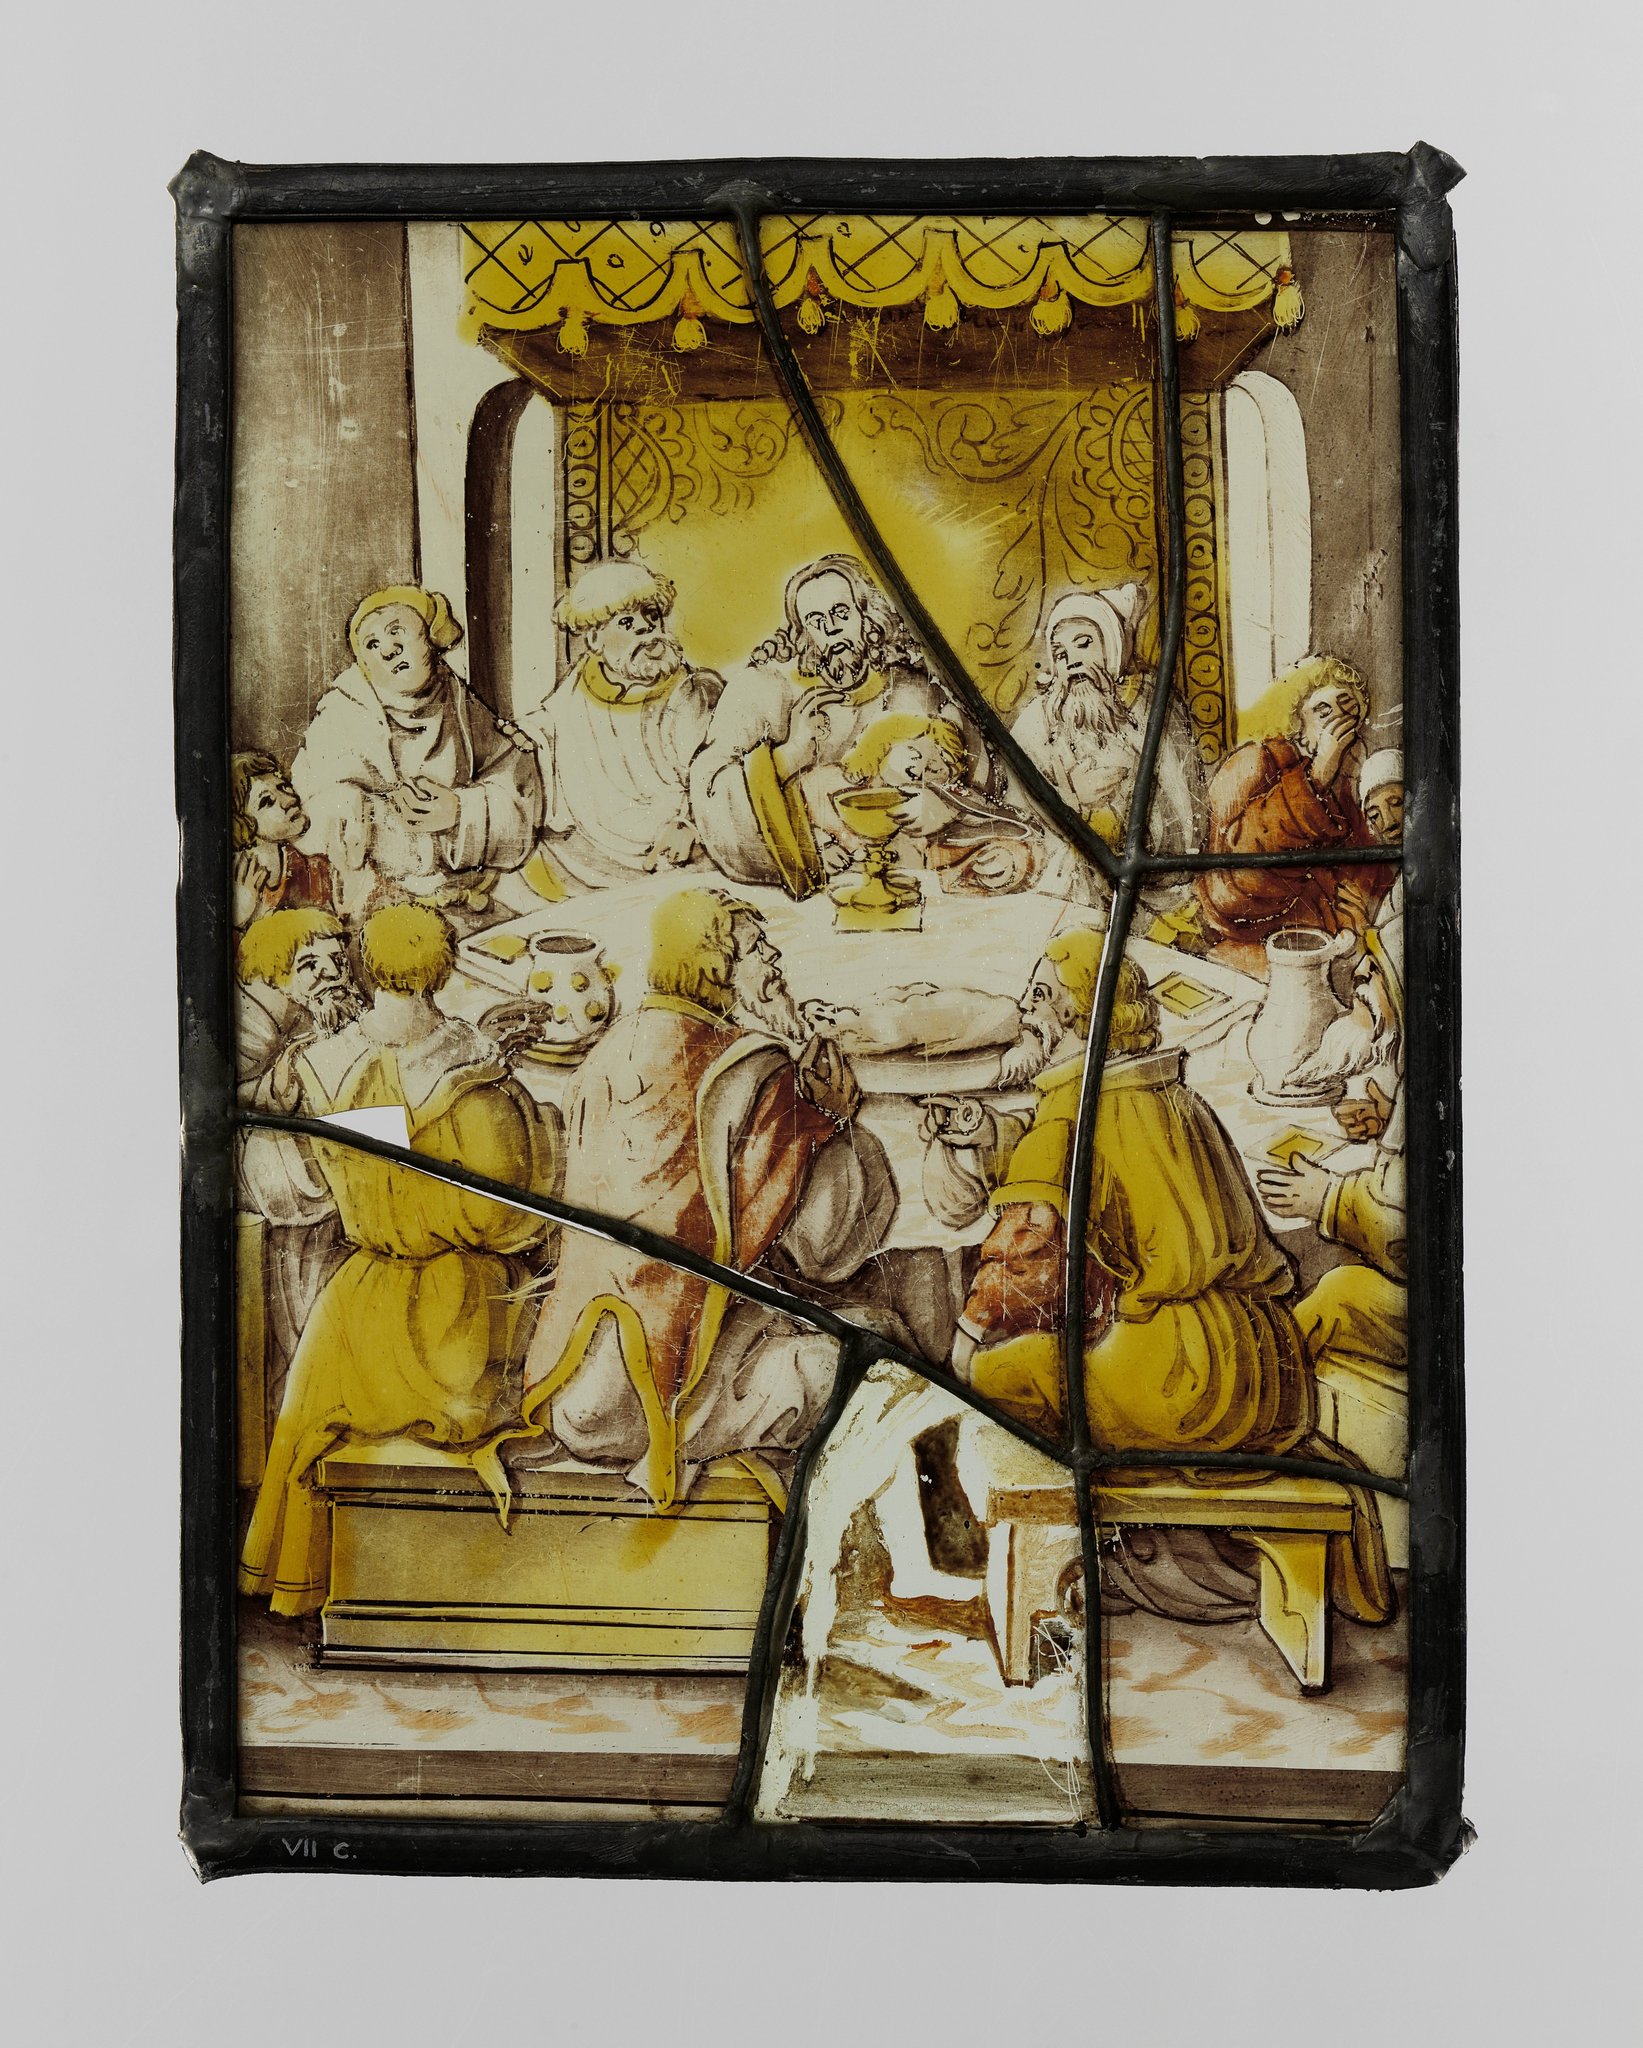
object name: light window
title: Ruit met het Laatste Avondmaal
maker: Anonymous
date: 1600-1700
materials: glass, lead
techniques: leading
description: Rechthoekige gebrandschilderde ruit in geel, bruin en rood met de voorstelling van het laatste avondmaal.